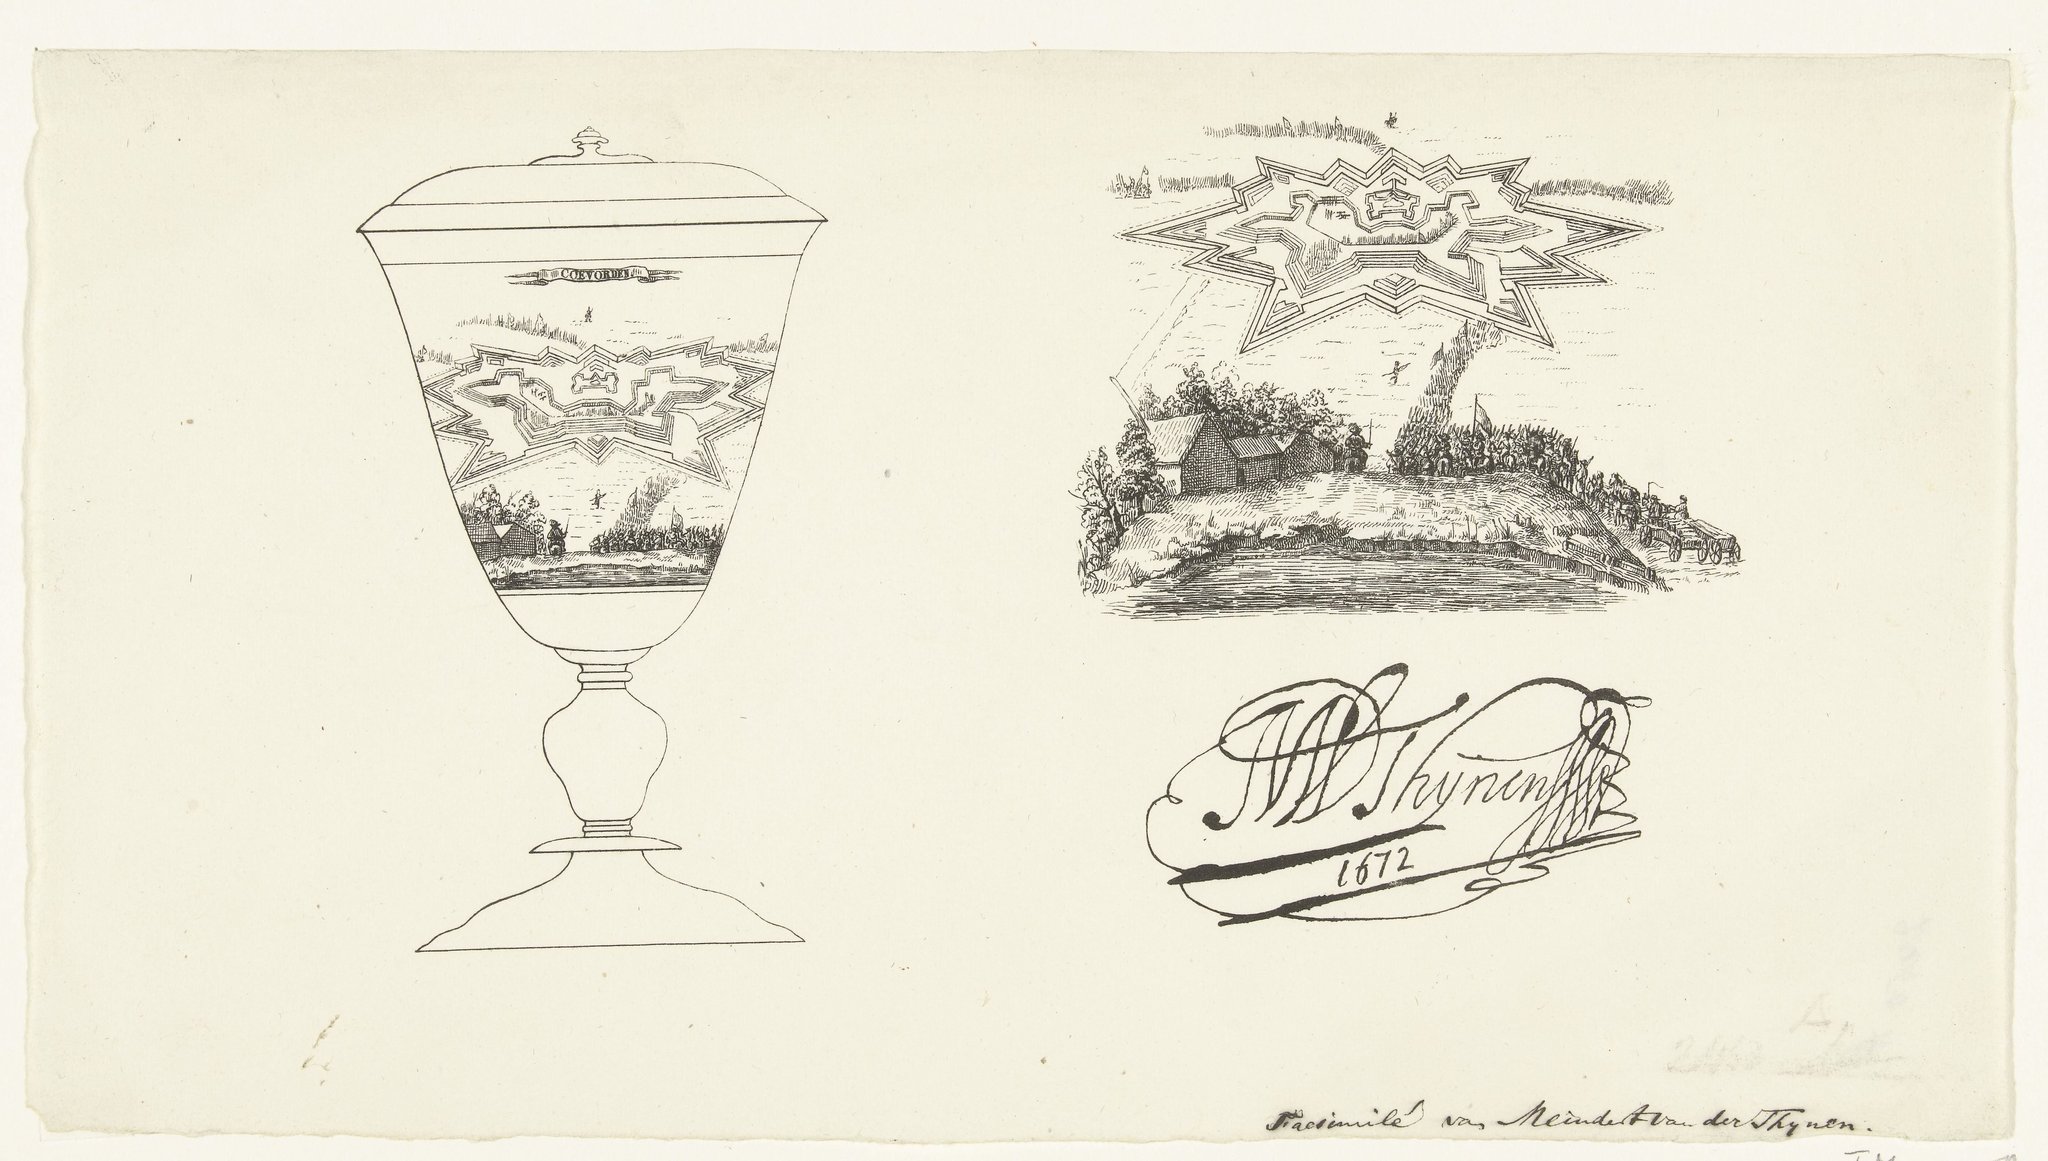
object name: print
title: Beker met het beleg van Coevorden, 1672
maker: Anonymous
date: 1800-1899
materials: paper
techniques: lithograph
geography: netherlands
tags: siege, position war, mug, beaker, goblet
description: Een beker met een voorstelling van de vesting van Coevorden, belegerd en veroverd op 30 december 1672 door de troepen van Karl Rabenhaupt op de legers van de bisschop van Munster. Met een detail van het beleg en de handtekening van de één van de voornaamste bevrijders Meindert van der Thynen.